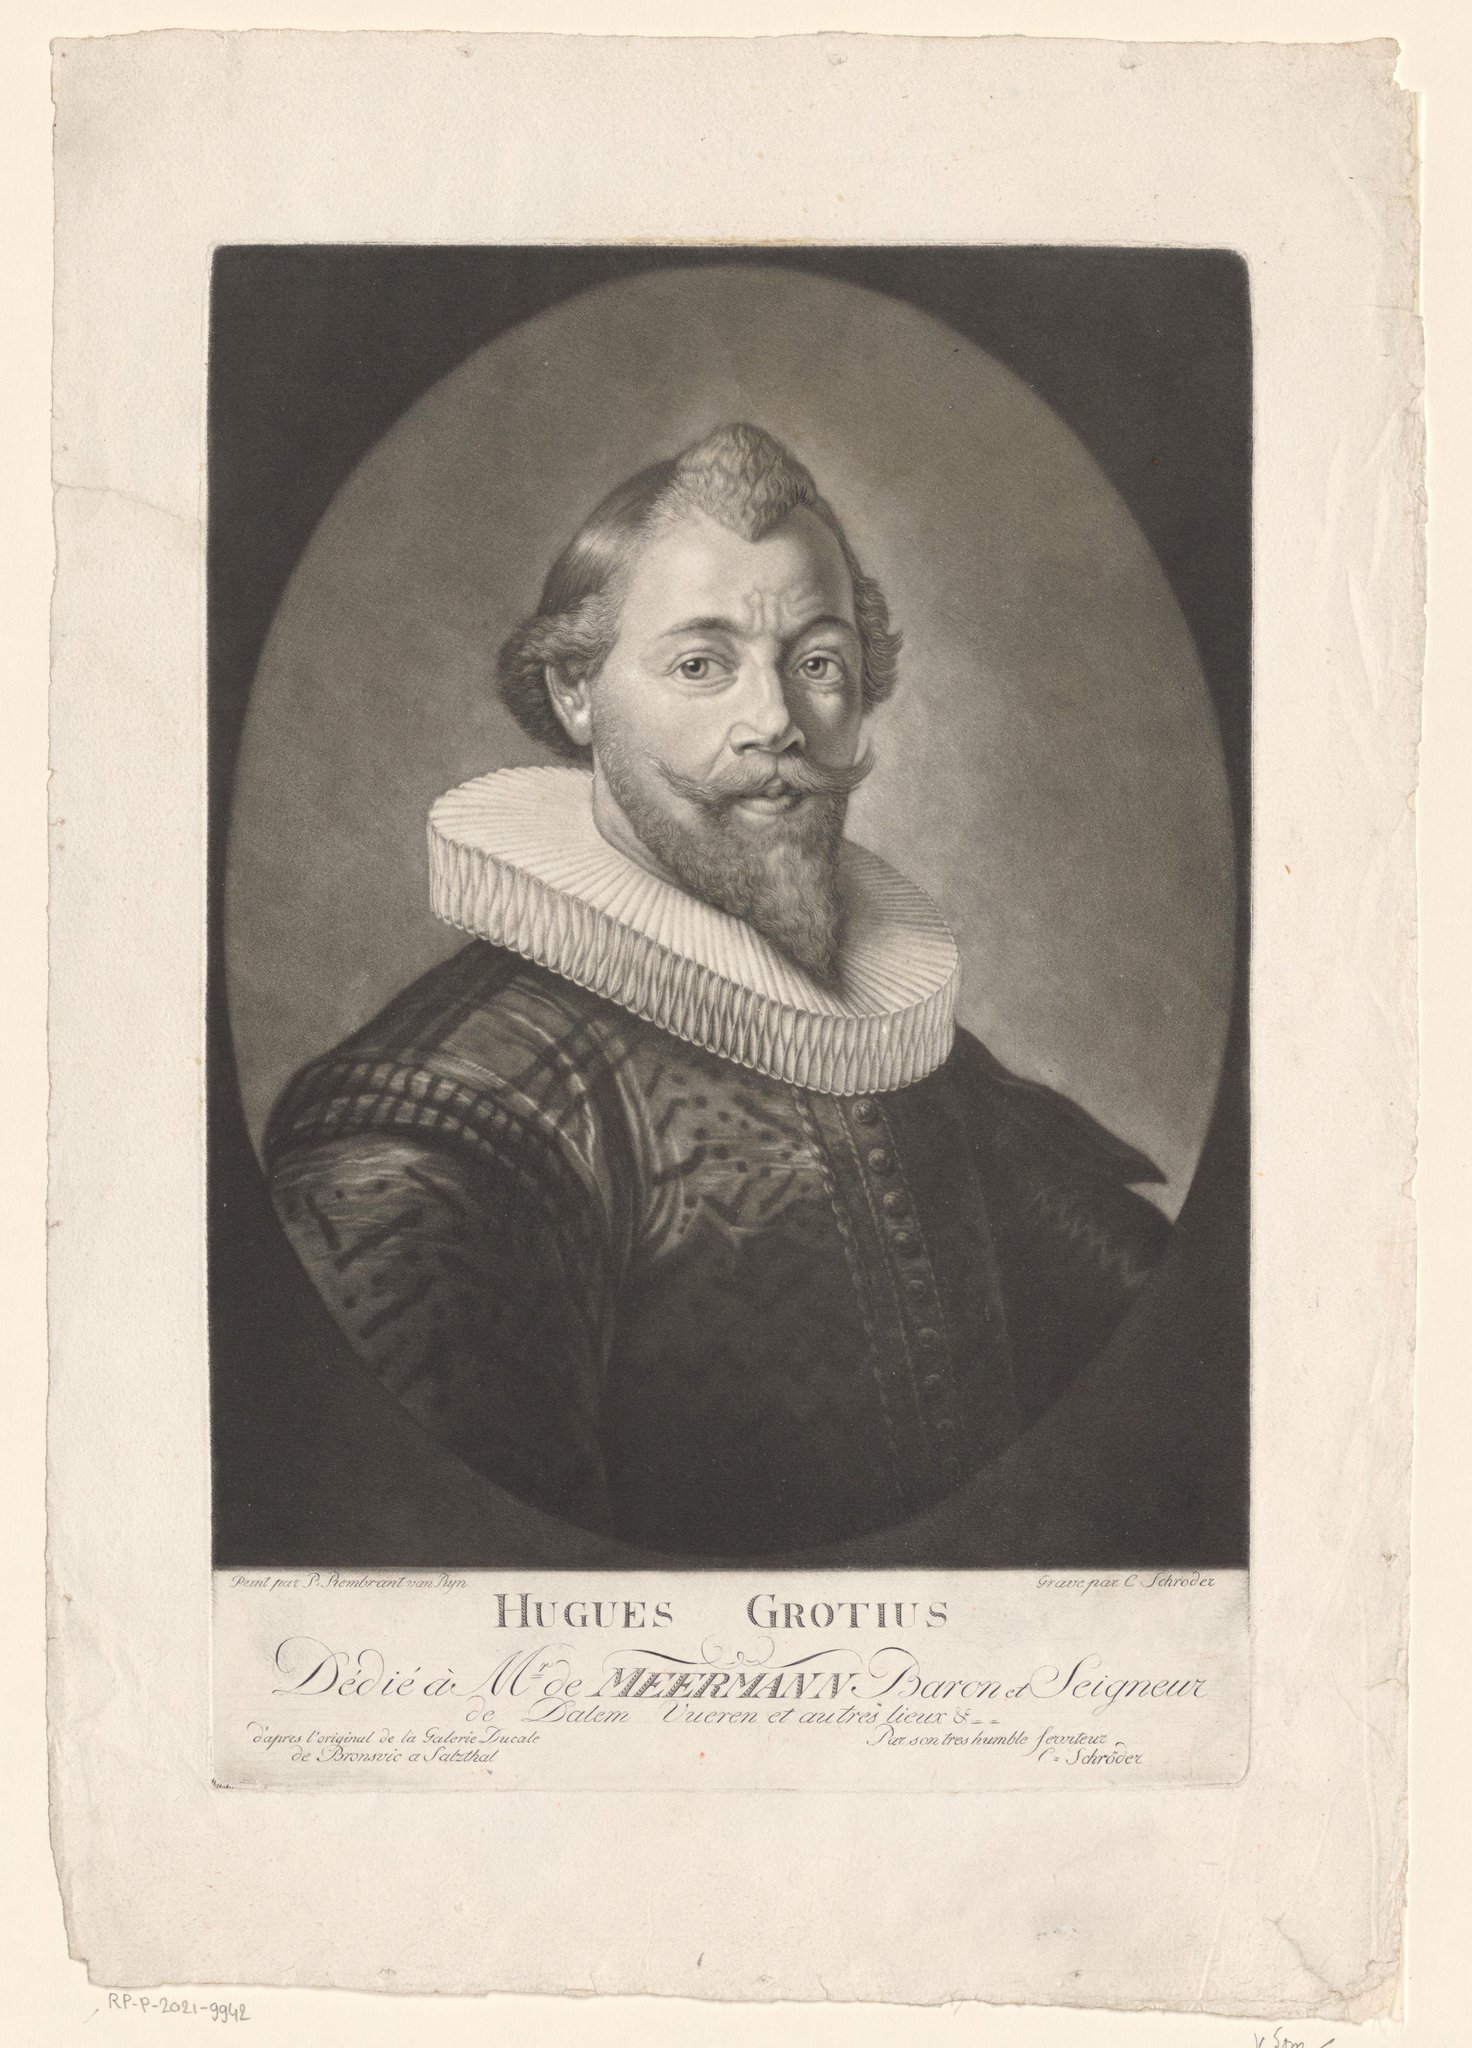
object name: print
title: Portret van Hugo van Groot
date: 1763-1815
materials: paper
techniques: engraving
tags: delft, hugo de groot, historical persons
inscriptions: collector's mark: Lugt 2228